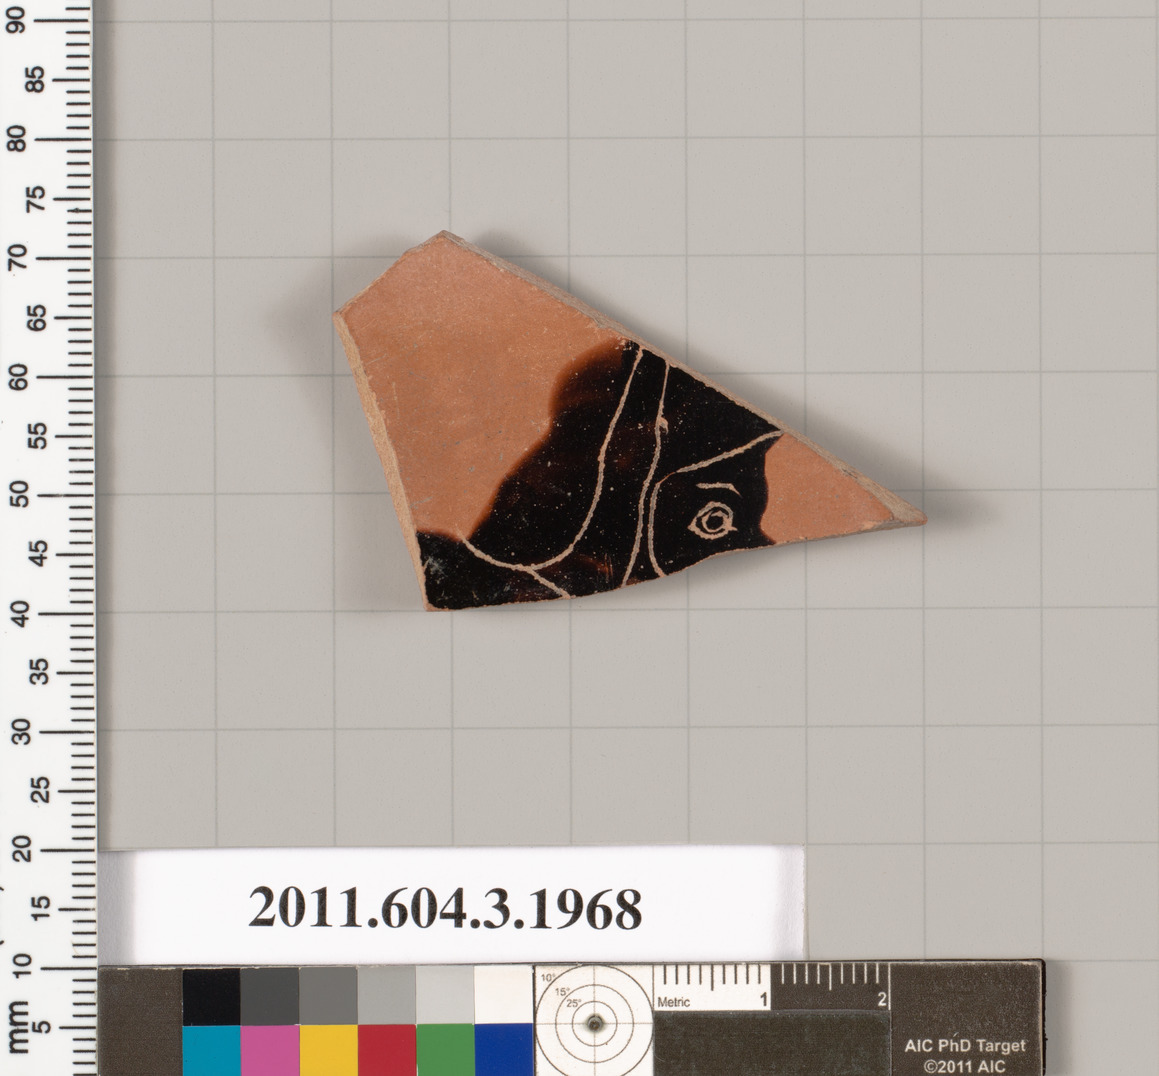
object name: kylix fragment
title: Terracotta fragment of a kylix (drinking cup)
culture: greek, attic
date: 550-526 BCE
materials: terracotta